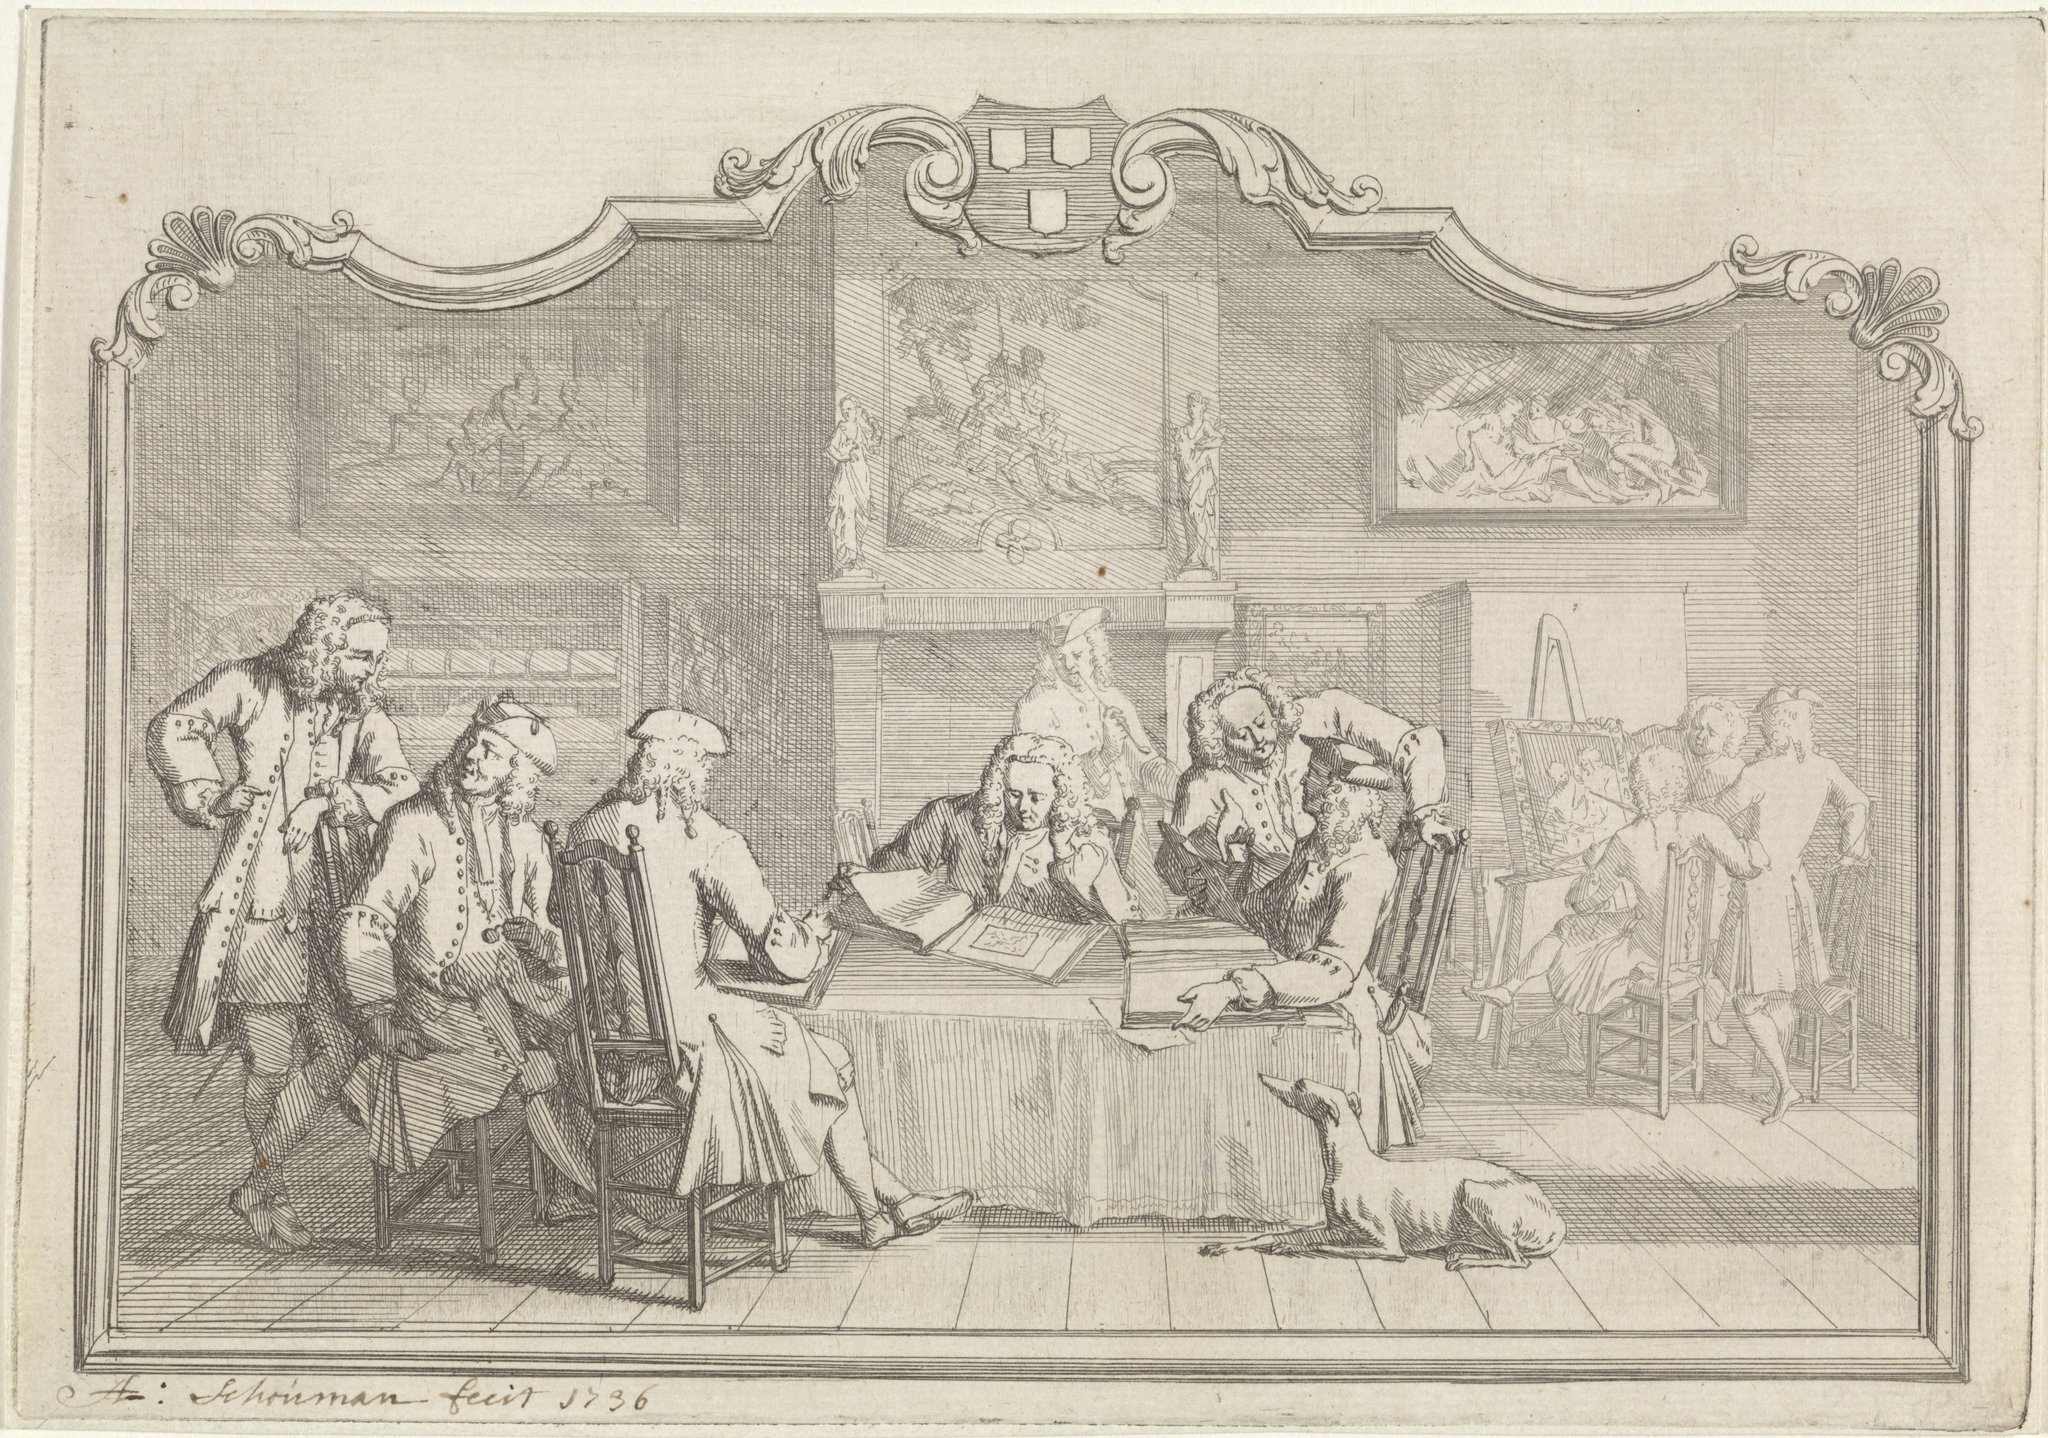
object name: print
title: Bijeenkomst van het broederschap St. Lukas te Dordrecht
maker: aert schouman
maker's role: draughtsman, painter, print maker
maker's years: 1710-1792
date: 1736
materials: paper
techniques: etching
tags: criticizing and discussing art, art criticism (+ professional organization ~ arts), guild of st. luke, dordrecht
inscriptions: inscription: ‘A. Schouman fecit 1736’, collector's mark: Lugt 2228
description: Kunstbeschouwing door leden van het in 1736 door Aert Schouman opgerichte broederschap van Sint Lukas, een vereniging van kunstliefhebbers en amateurs voor Dordrecht en omstreken. Op de achtergrond een schilder voor zijn ezel in gesprek met twee heren. In de lijst het wapen van St Lukas.